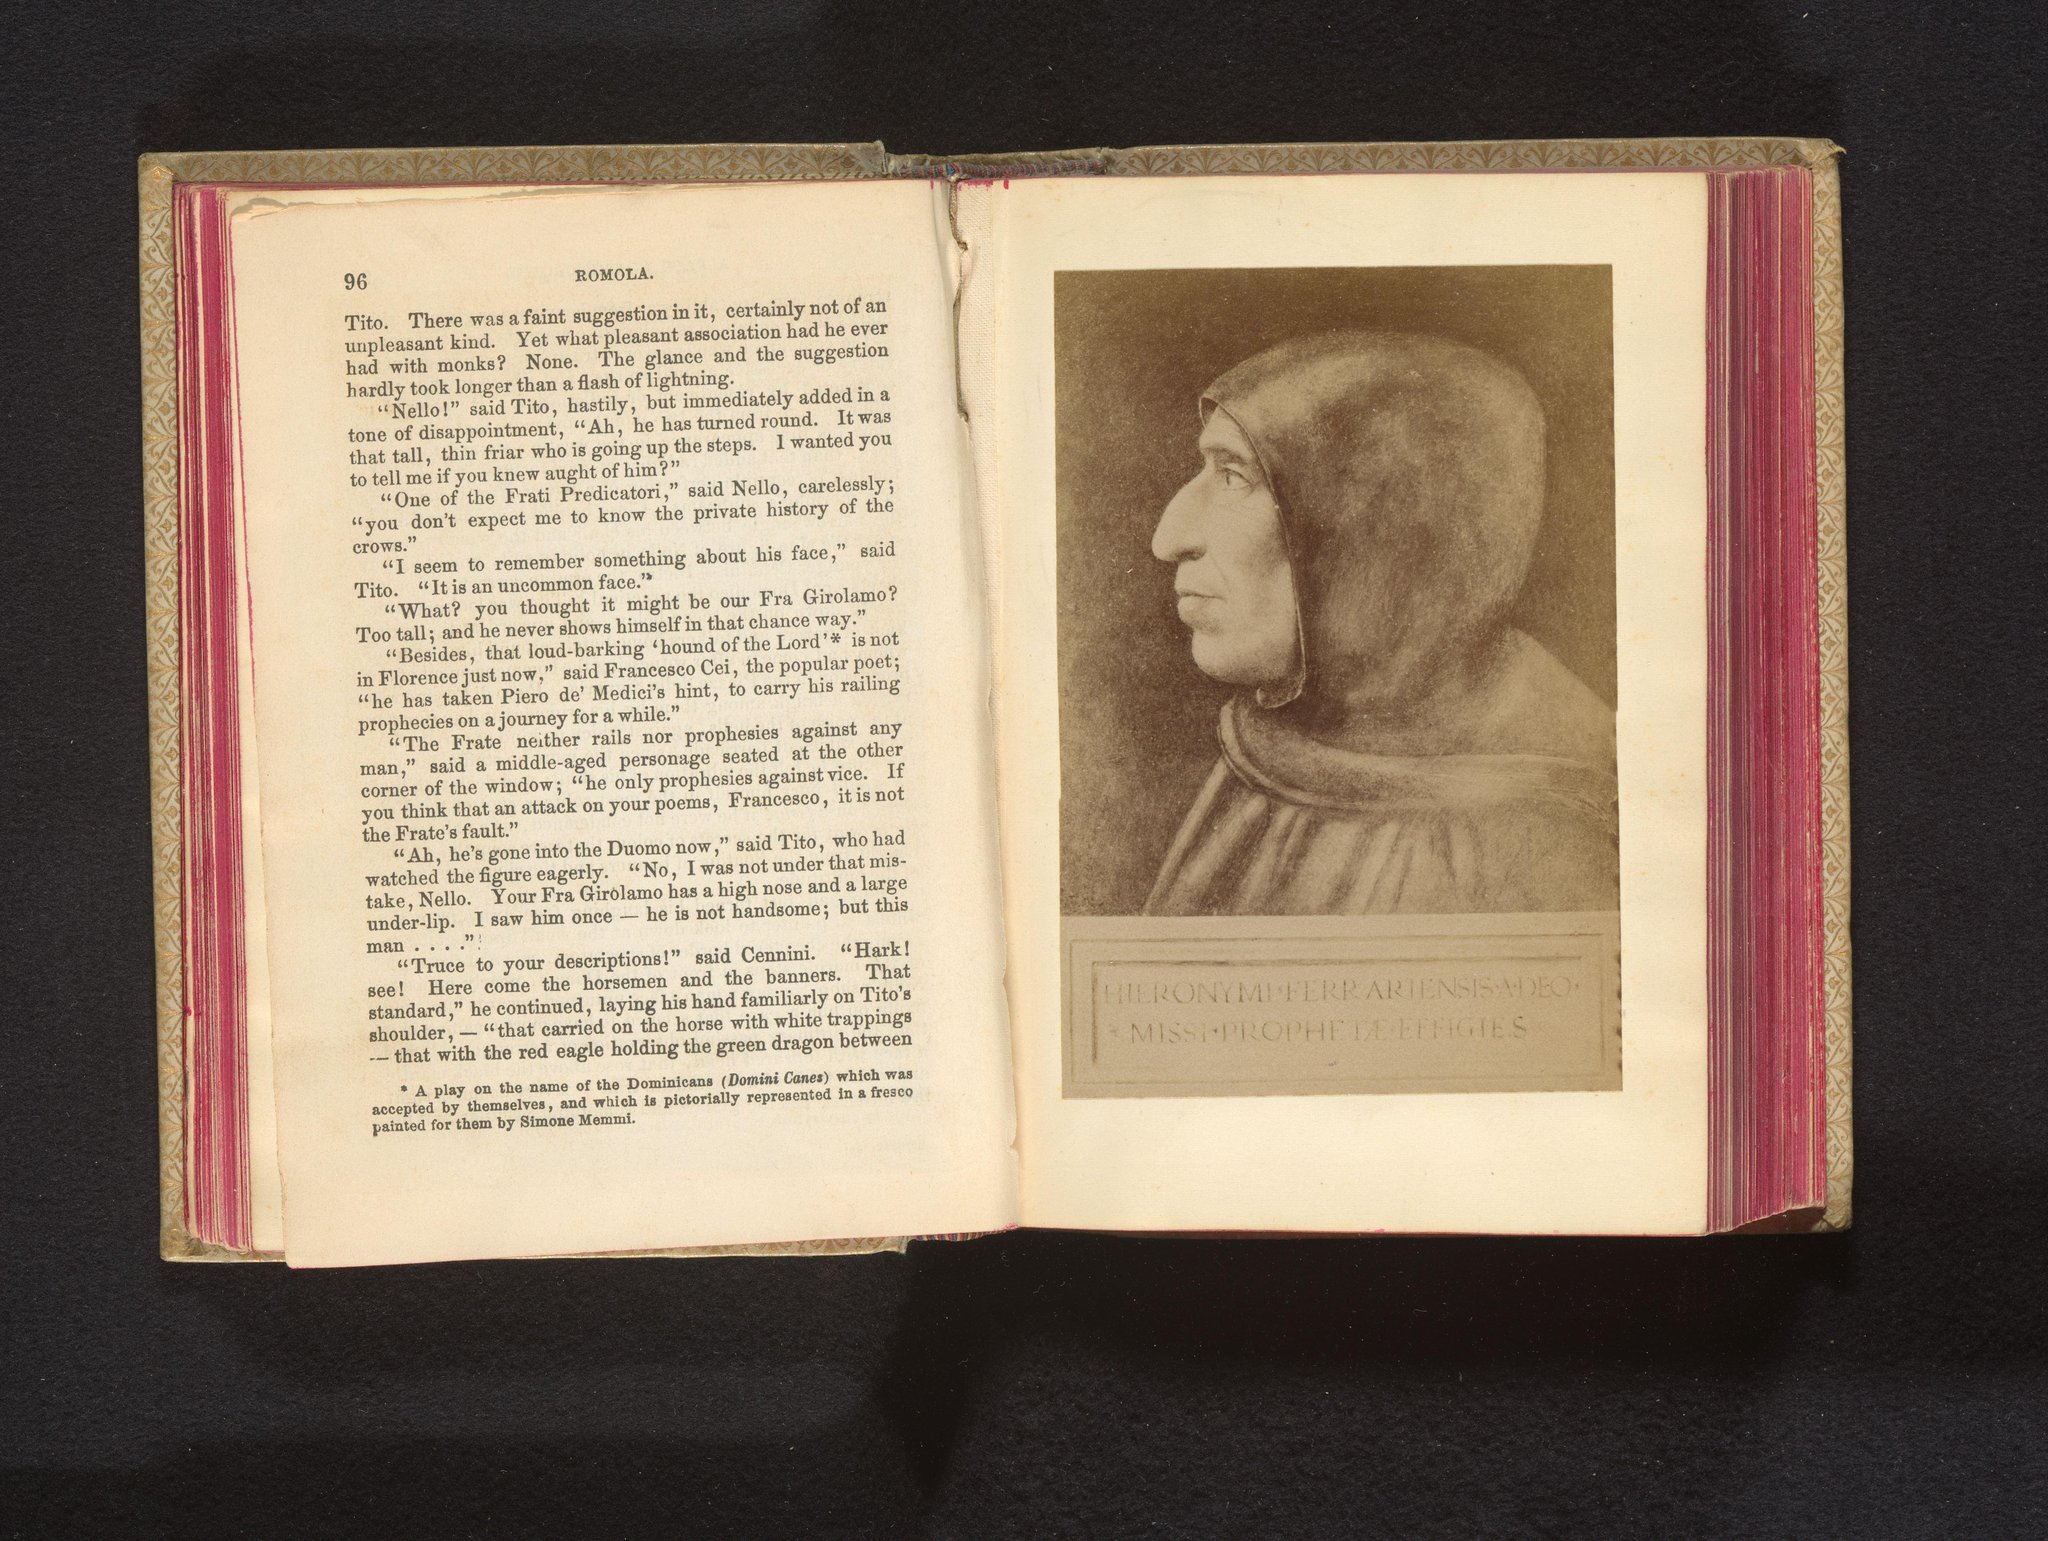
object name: photograph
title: Fotoreproductie van een schilderij, voorstellende een portret van Girolamo Savonarola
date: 1858-1863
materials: photographic support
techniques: albumen print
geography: florence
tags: priest, politician, historical persons